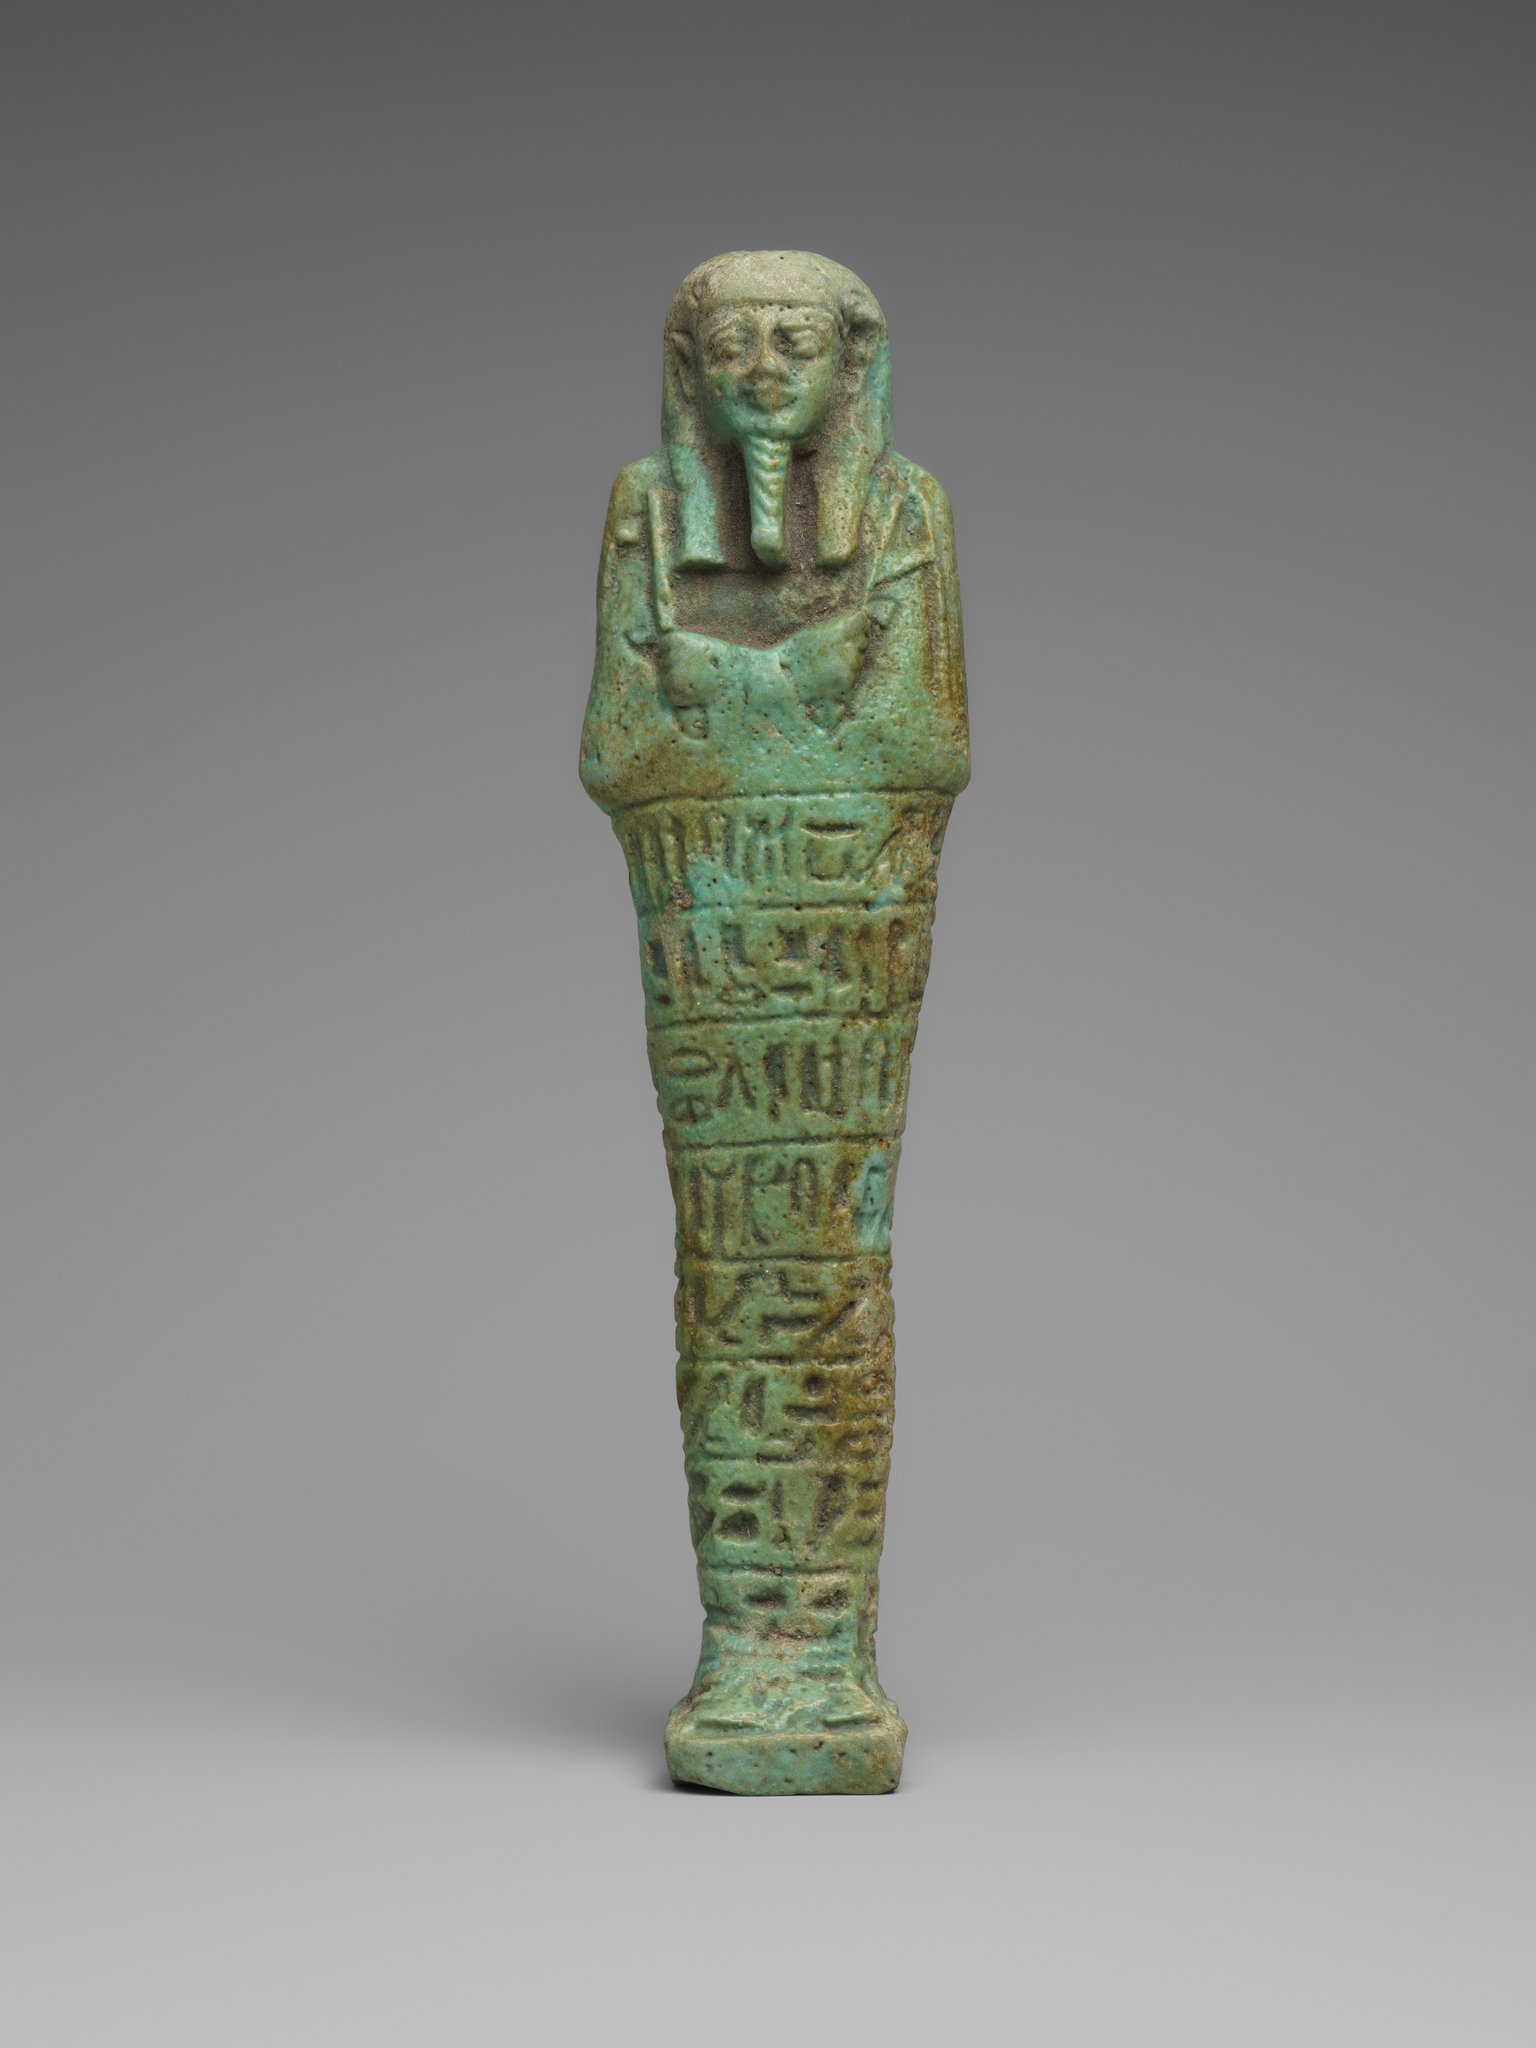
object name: shabti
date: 522-30 BCE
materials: faience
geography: greece